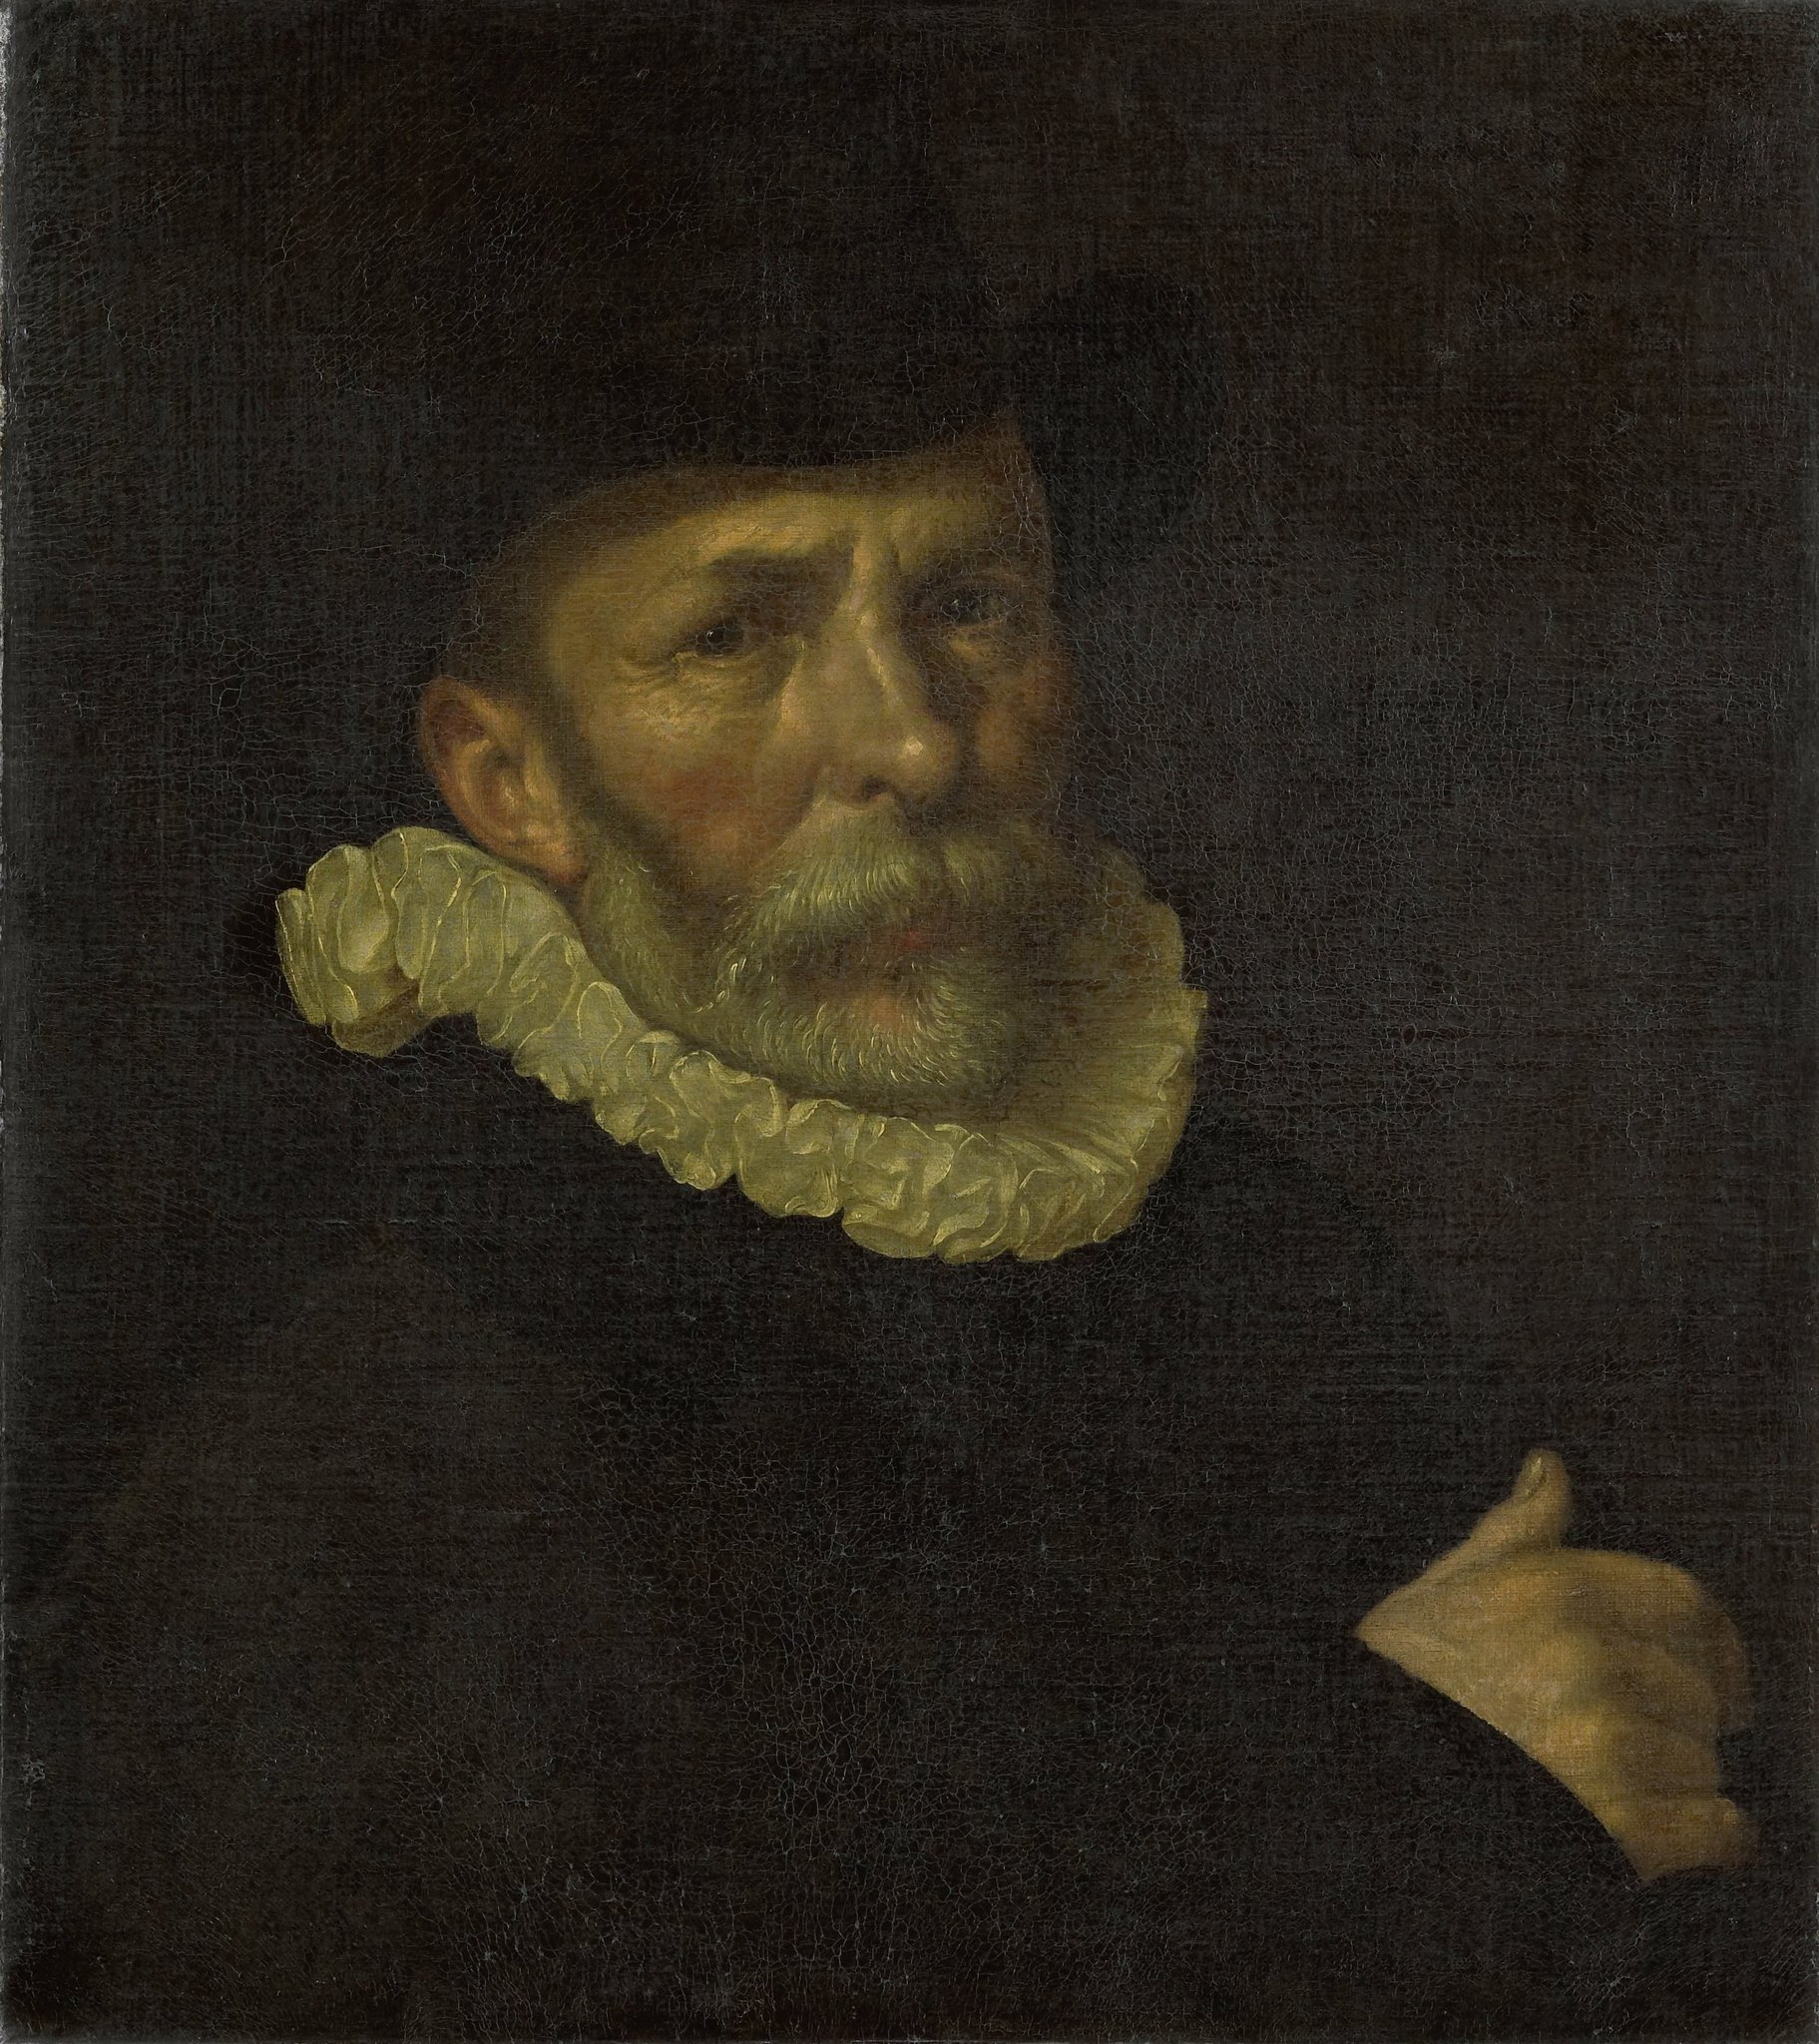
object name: painting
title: Dirck Barendsz (1534-92), Painter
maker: cornelis ketel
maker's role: draughtsman, painter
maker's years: 1548-1616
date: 1590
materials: canvas, oil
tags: amsterdam, draughtsman, dirck barendsz., historical persons, portrait, self-portrait of artist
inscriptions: signature, date and inscription: ‘Aetatis 55 1590 CK F. Swygende hoop ick’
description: Portret van de schilder Dirck Barendsz. Buste, naar rechts, met een zwarte hoed.